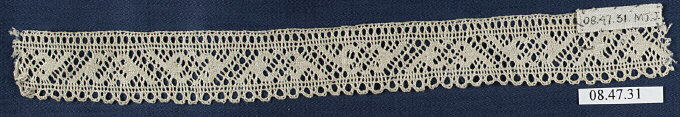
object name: fragment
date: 1801-1900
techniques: lace